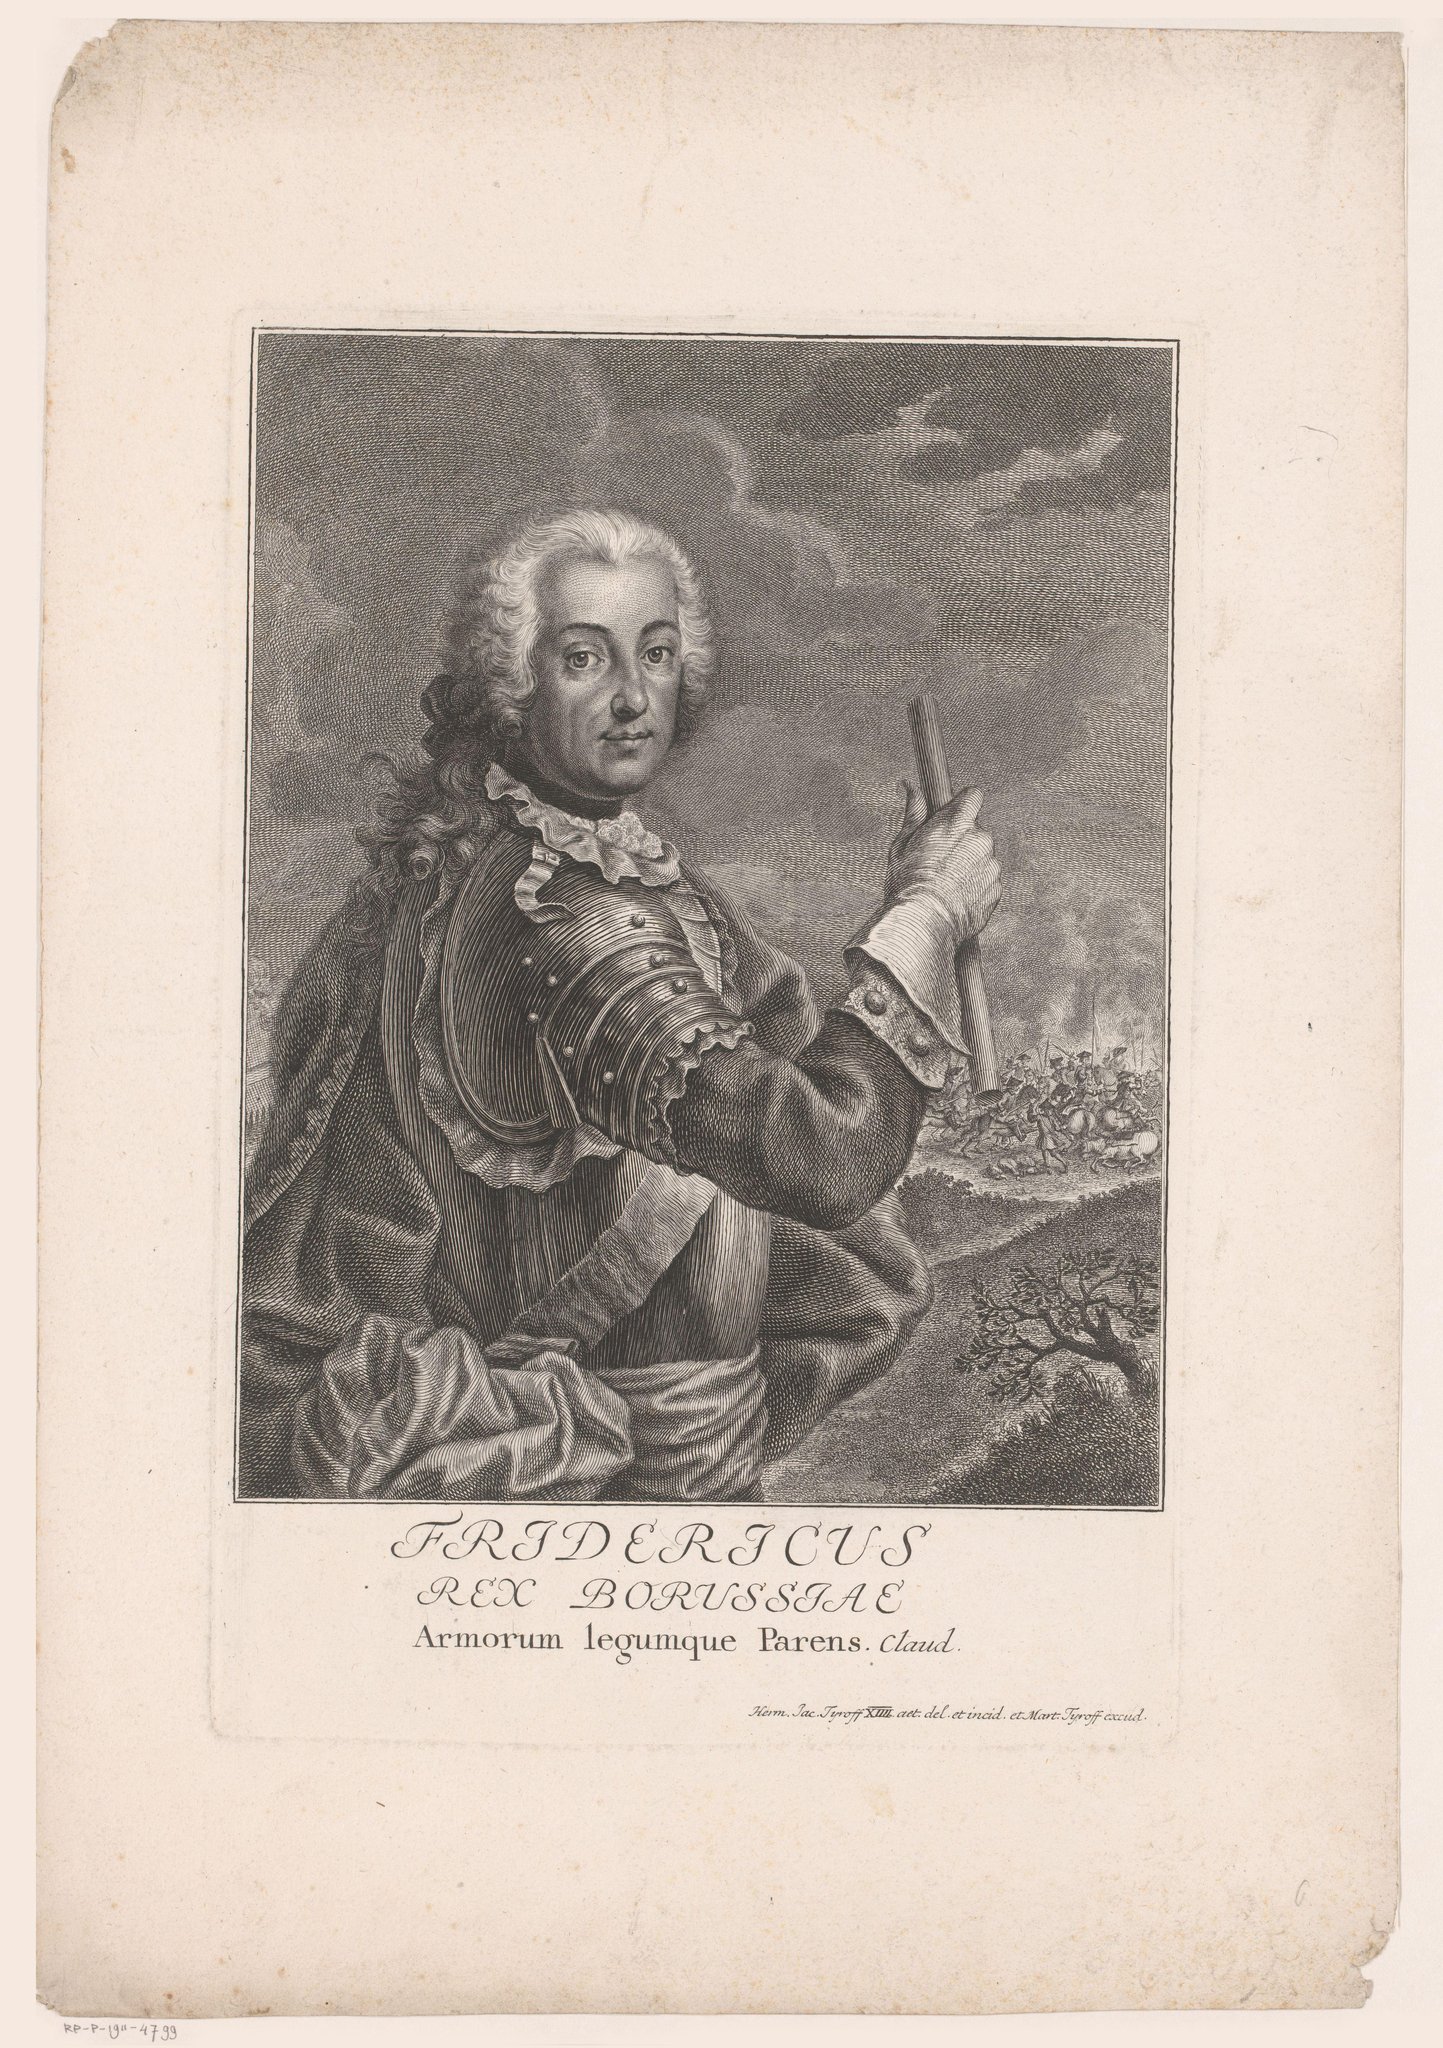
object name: print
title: Portret van Frederik II, koning van Pruisen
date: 1752-1798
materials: paper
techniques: engraving, etching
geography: germany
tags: berlin, frederick ii (king of prussia), armour, historical persons, baton of general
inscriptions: collector's mark: Lugt 2228